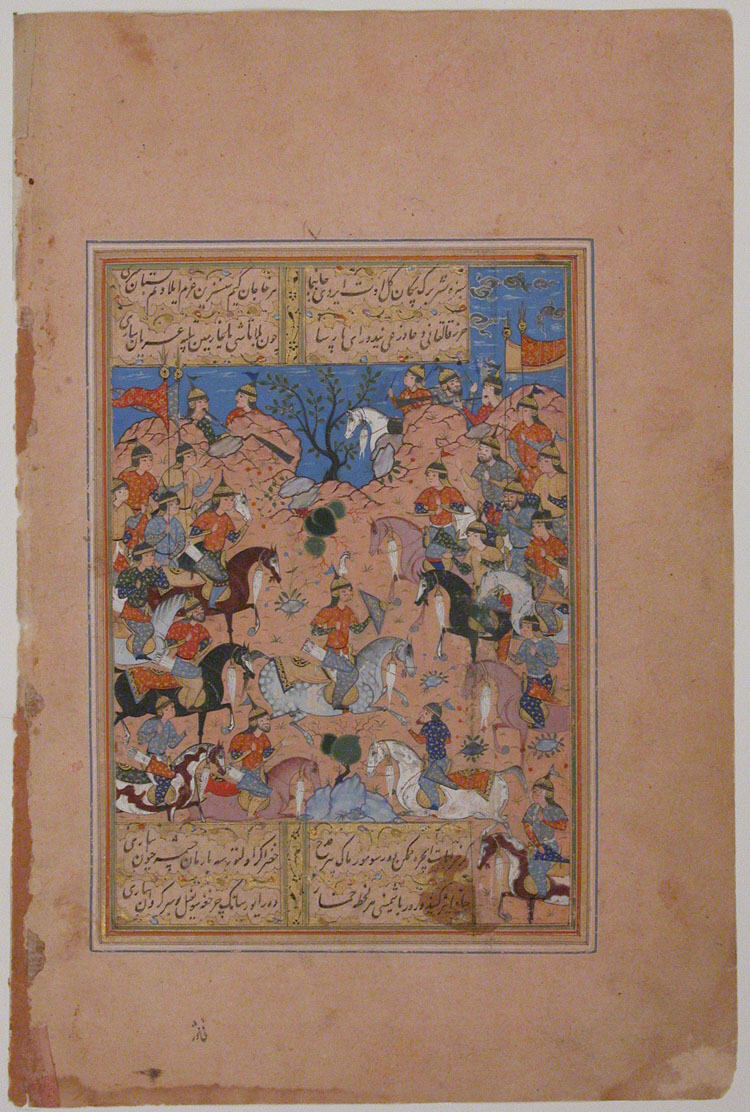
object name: folio from an illustrated manuscript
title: "A Tournament at Arms", Folio from a Divan (Collected Works) of Mir 'Ali Shir Nava'i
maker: mir 'ali shir nava'i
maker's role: author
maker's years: 1416-1476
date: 1580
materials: gold, ink, paper, watercolor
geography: iran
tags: men,horses